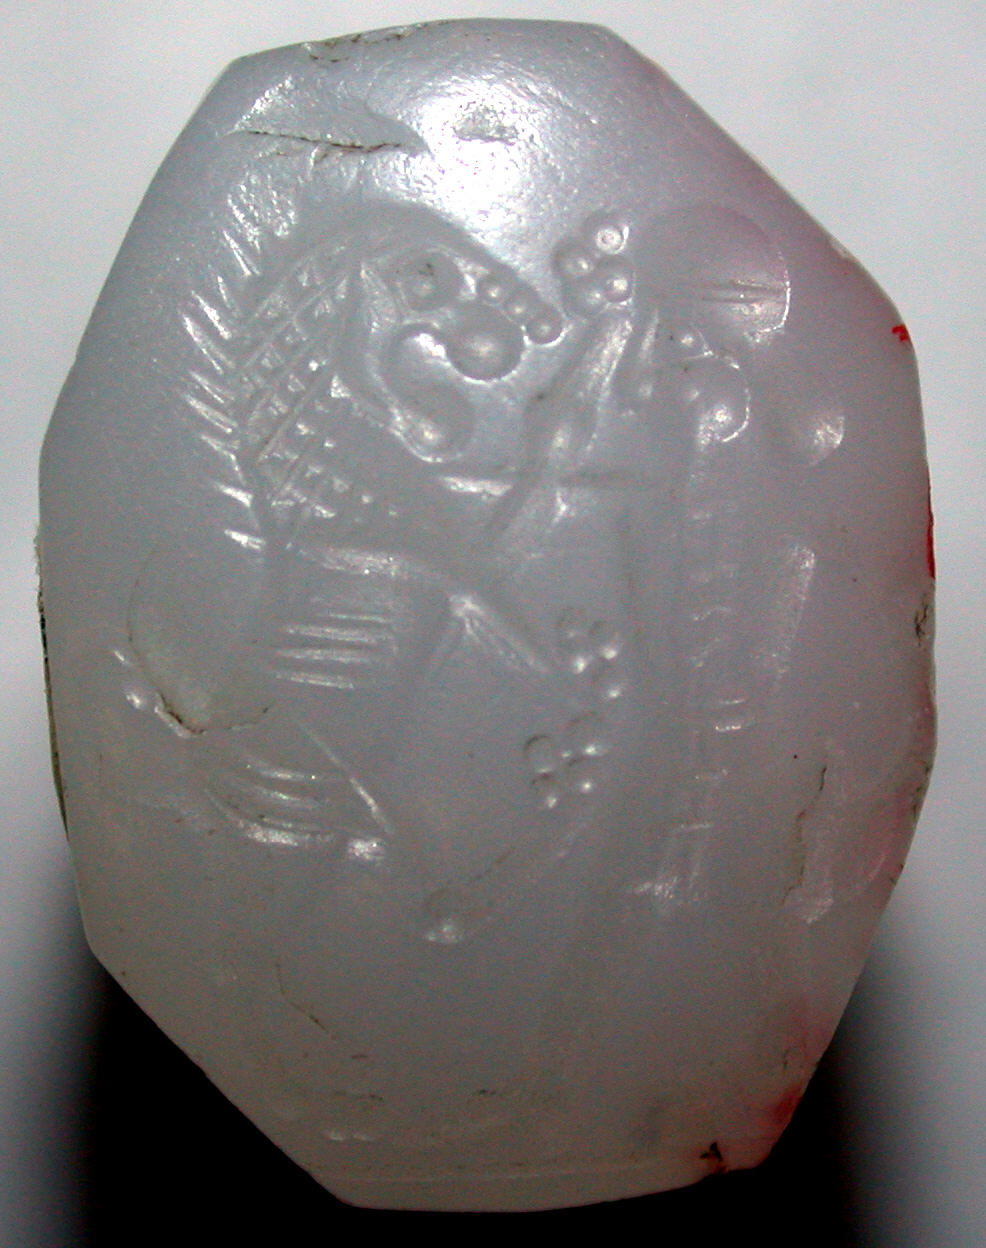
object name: stamp seal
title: Octagonal pyramidal seal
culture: achaemenid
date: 600-401 BCE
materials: stone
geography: iran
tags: animals